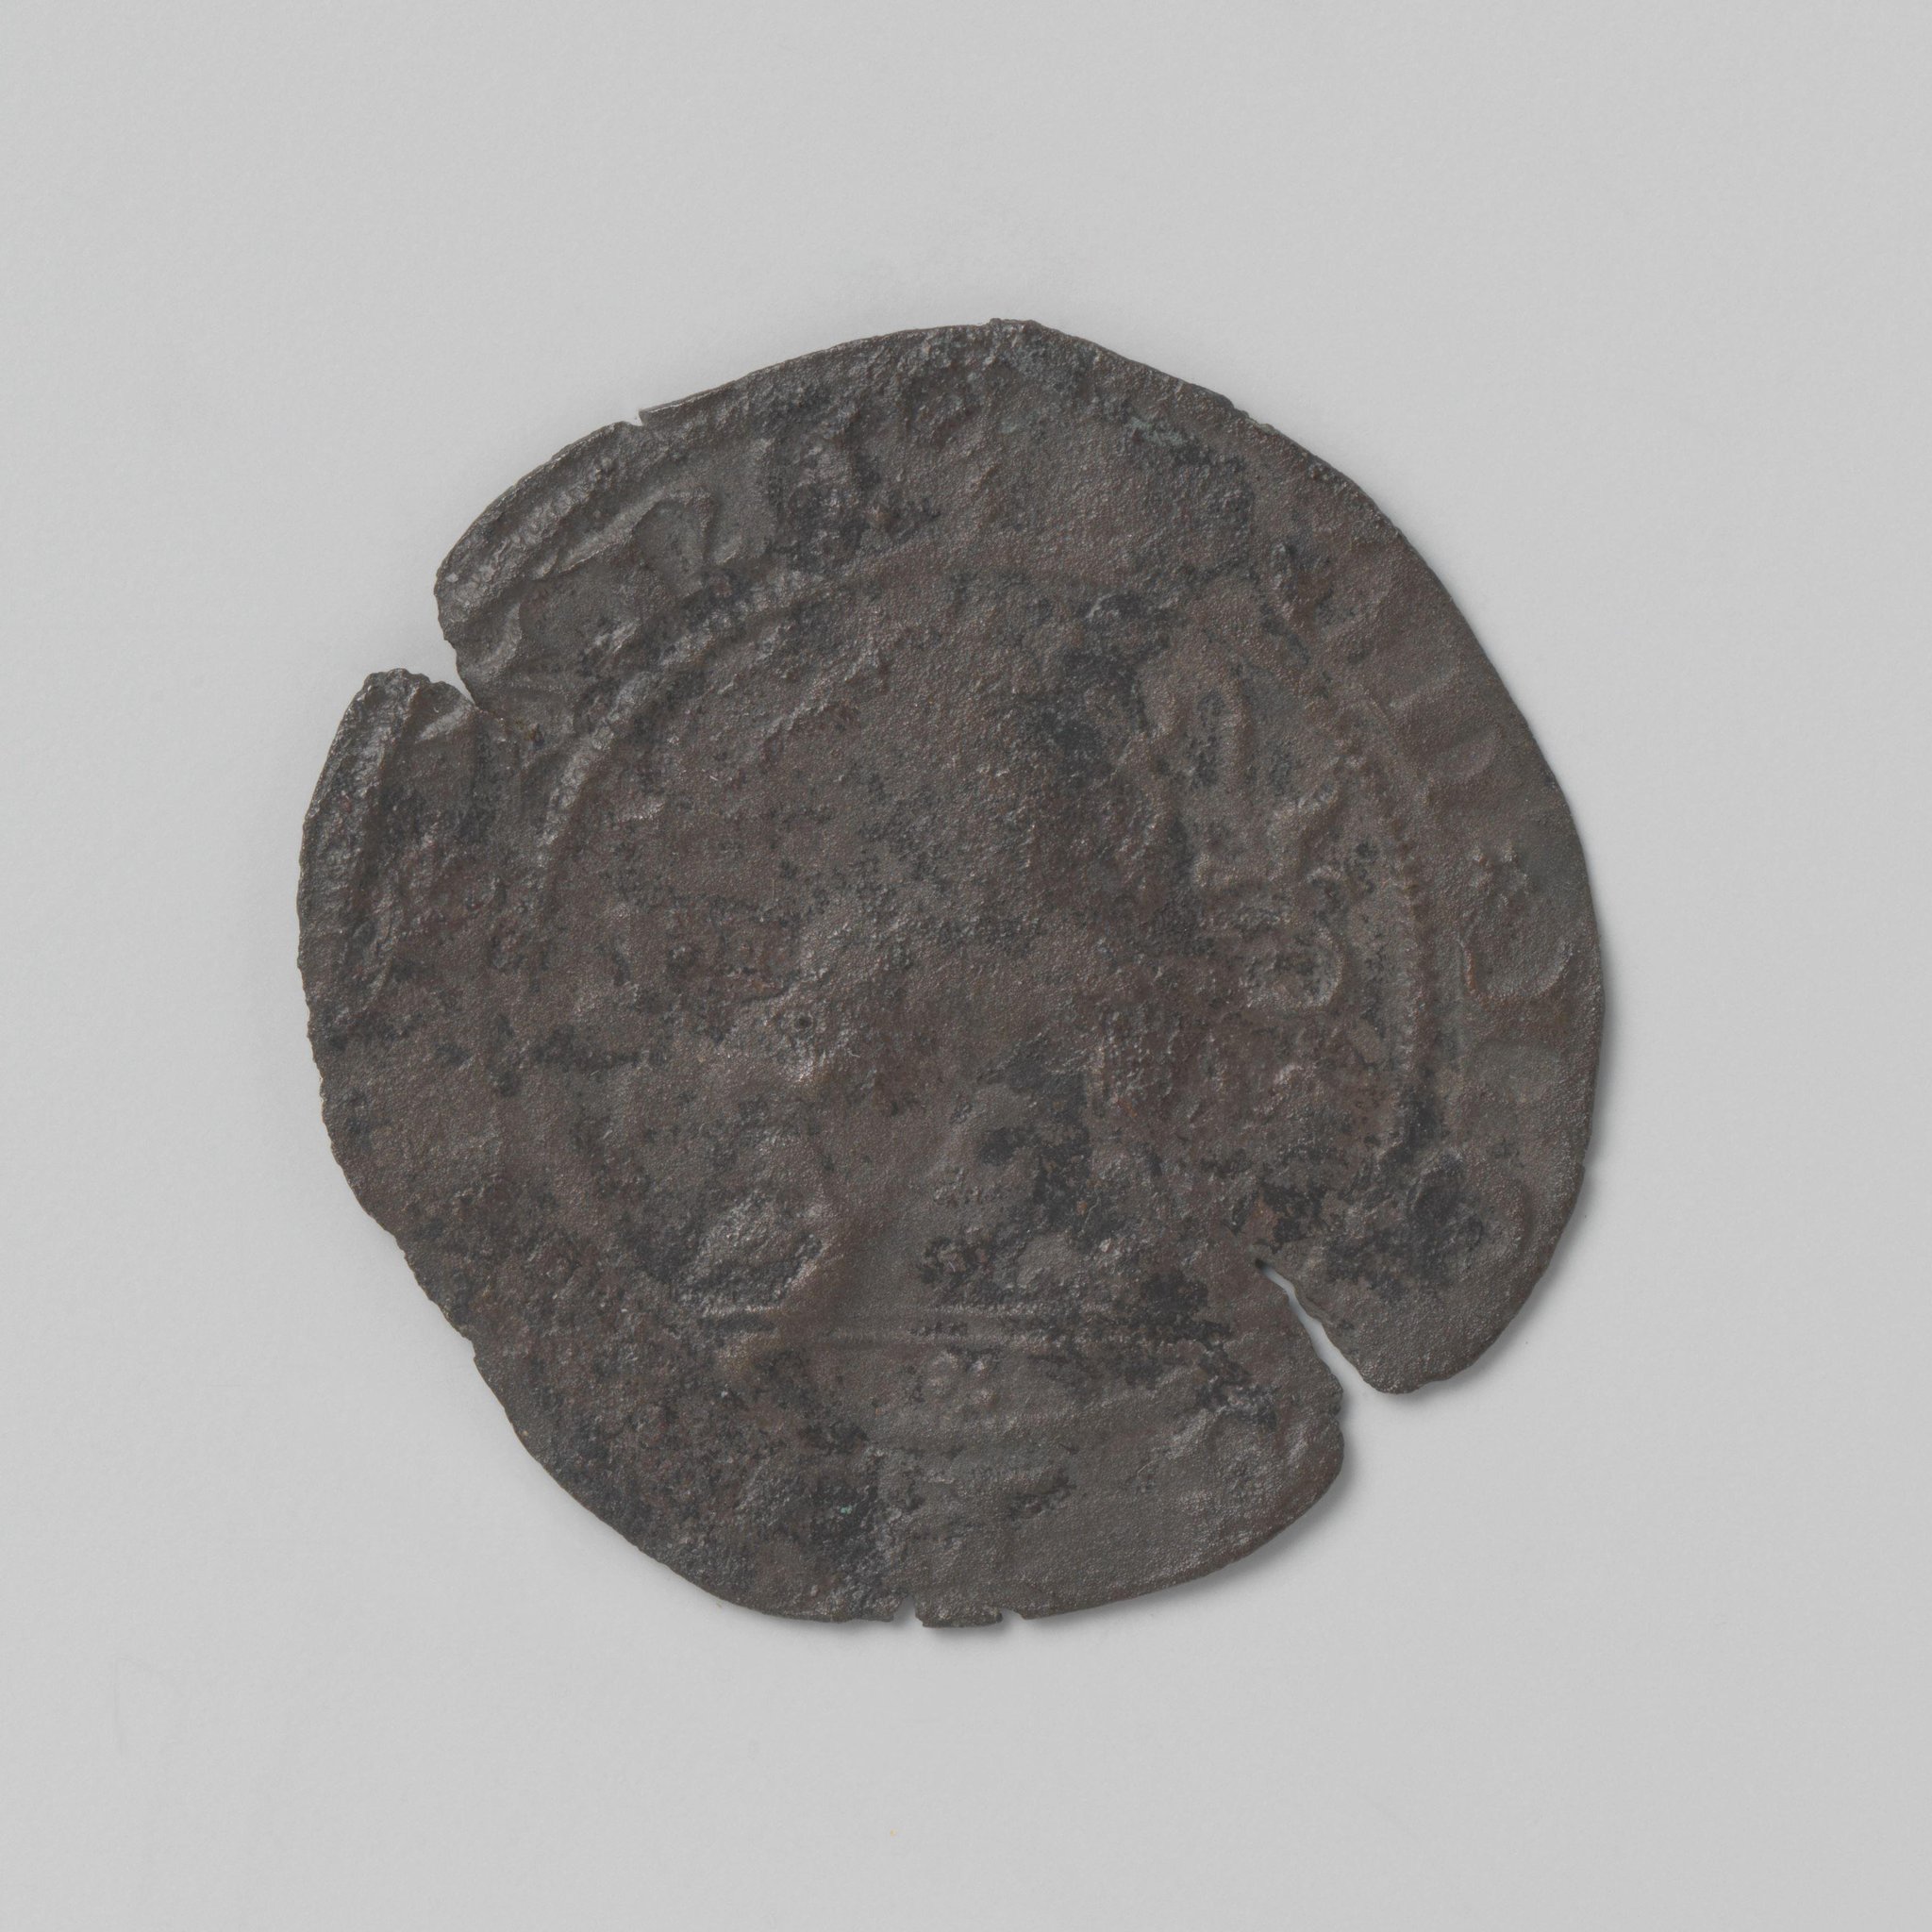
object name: half vuurijzer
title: Franeker, half vuurijzer, 1488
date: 1488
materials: silver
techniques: striking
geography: franeker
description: Zilveren munt. Voorzijde: gaande leeuw naar links boven afsnede, waarin sterretje Keerzijde: kort gebloemd kruis. In omschrift jaartal.